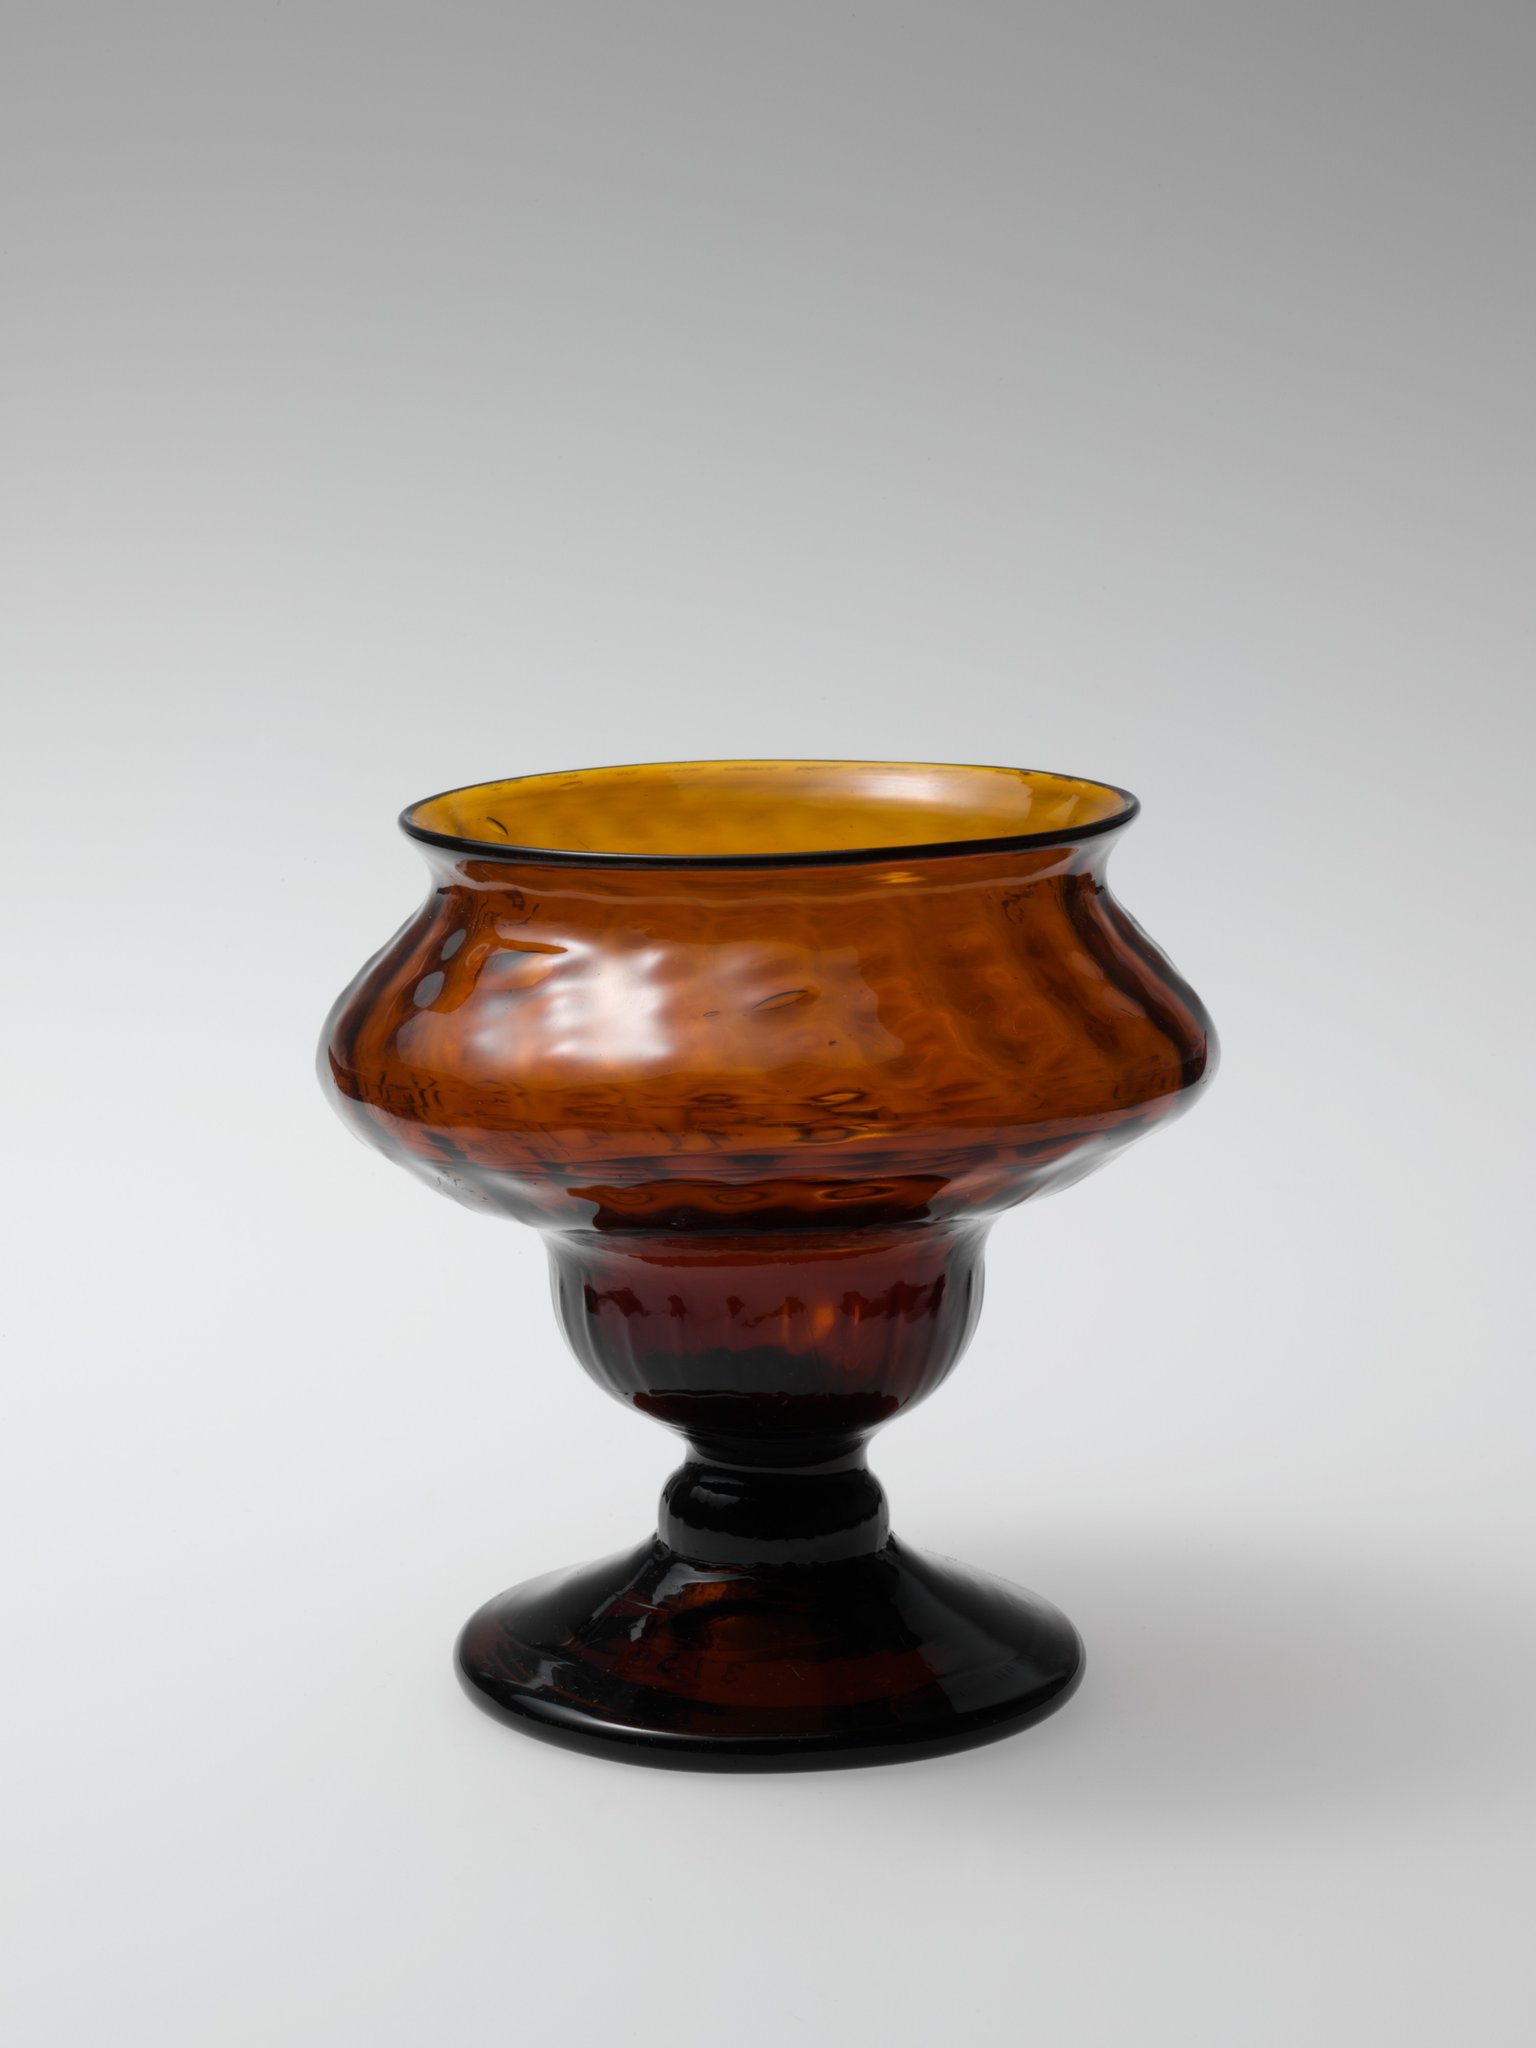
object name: salt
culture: american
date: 1815-1835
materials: glass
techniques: glassblowing, molding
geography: united states